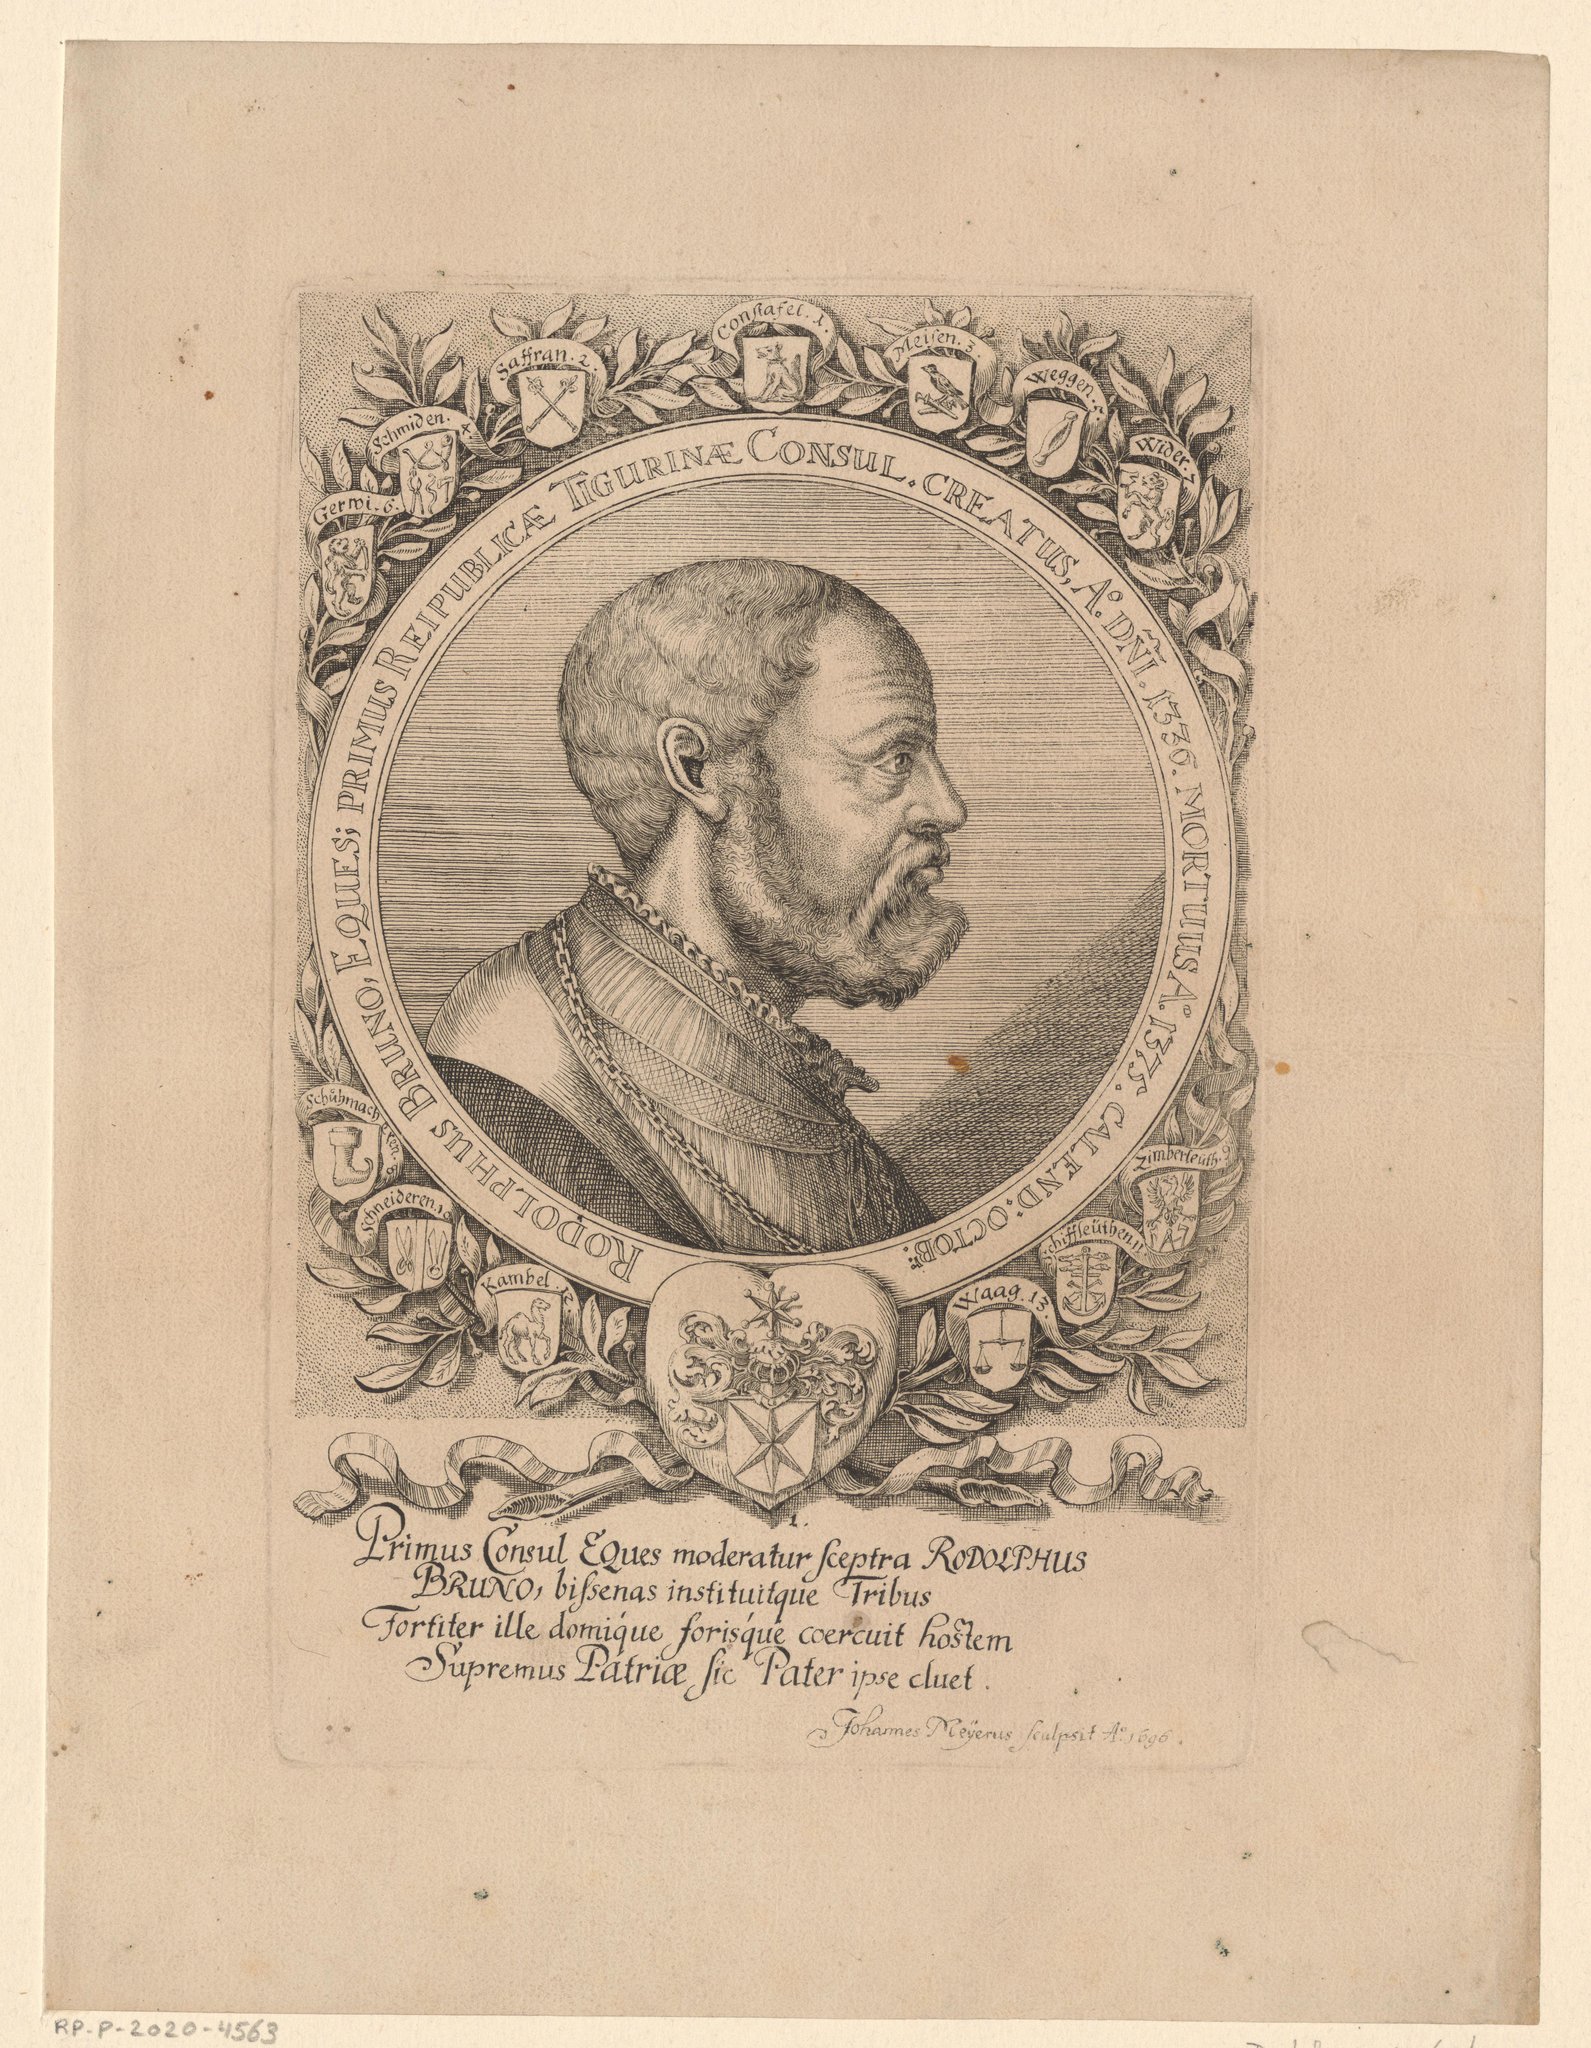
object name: print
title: Portret van Rudolf Brun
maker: johannes meyer (ii)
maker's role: print maker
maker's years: 1655-1712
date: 1696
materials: paper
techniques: engraving, etching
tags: mayor, theologian, historical persons, armorial bearing, heraldry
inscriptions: date